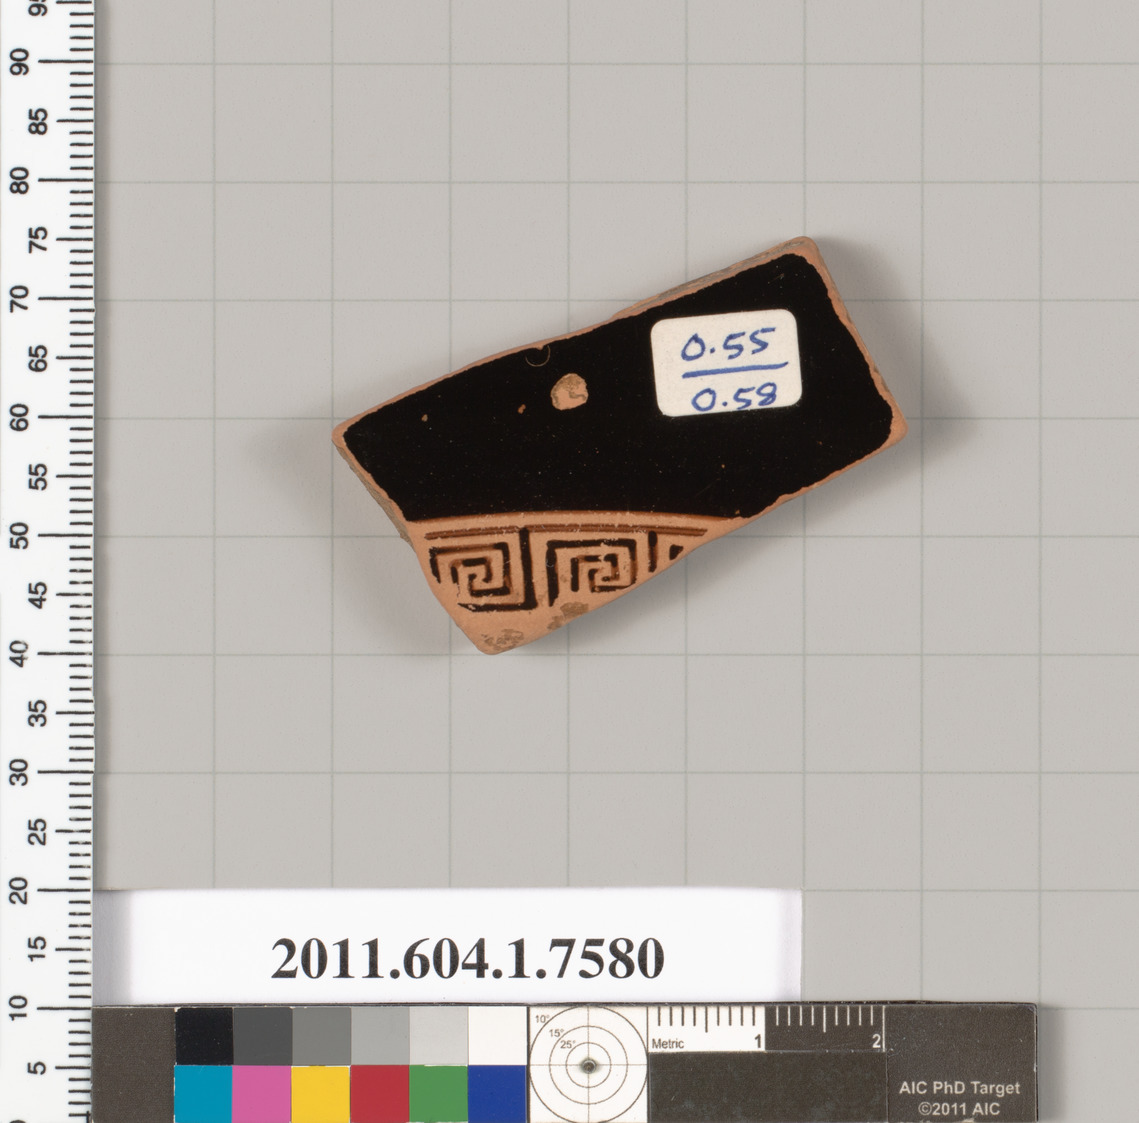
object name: kylix fragment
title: Terracotta fragment of a kylix (drinking cup)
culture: greek, attic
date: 460-450 BCE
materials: terracotta